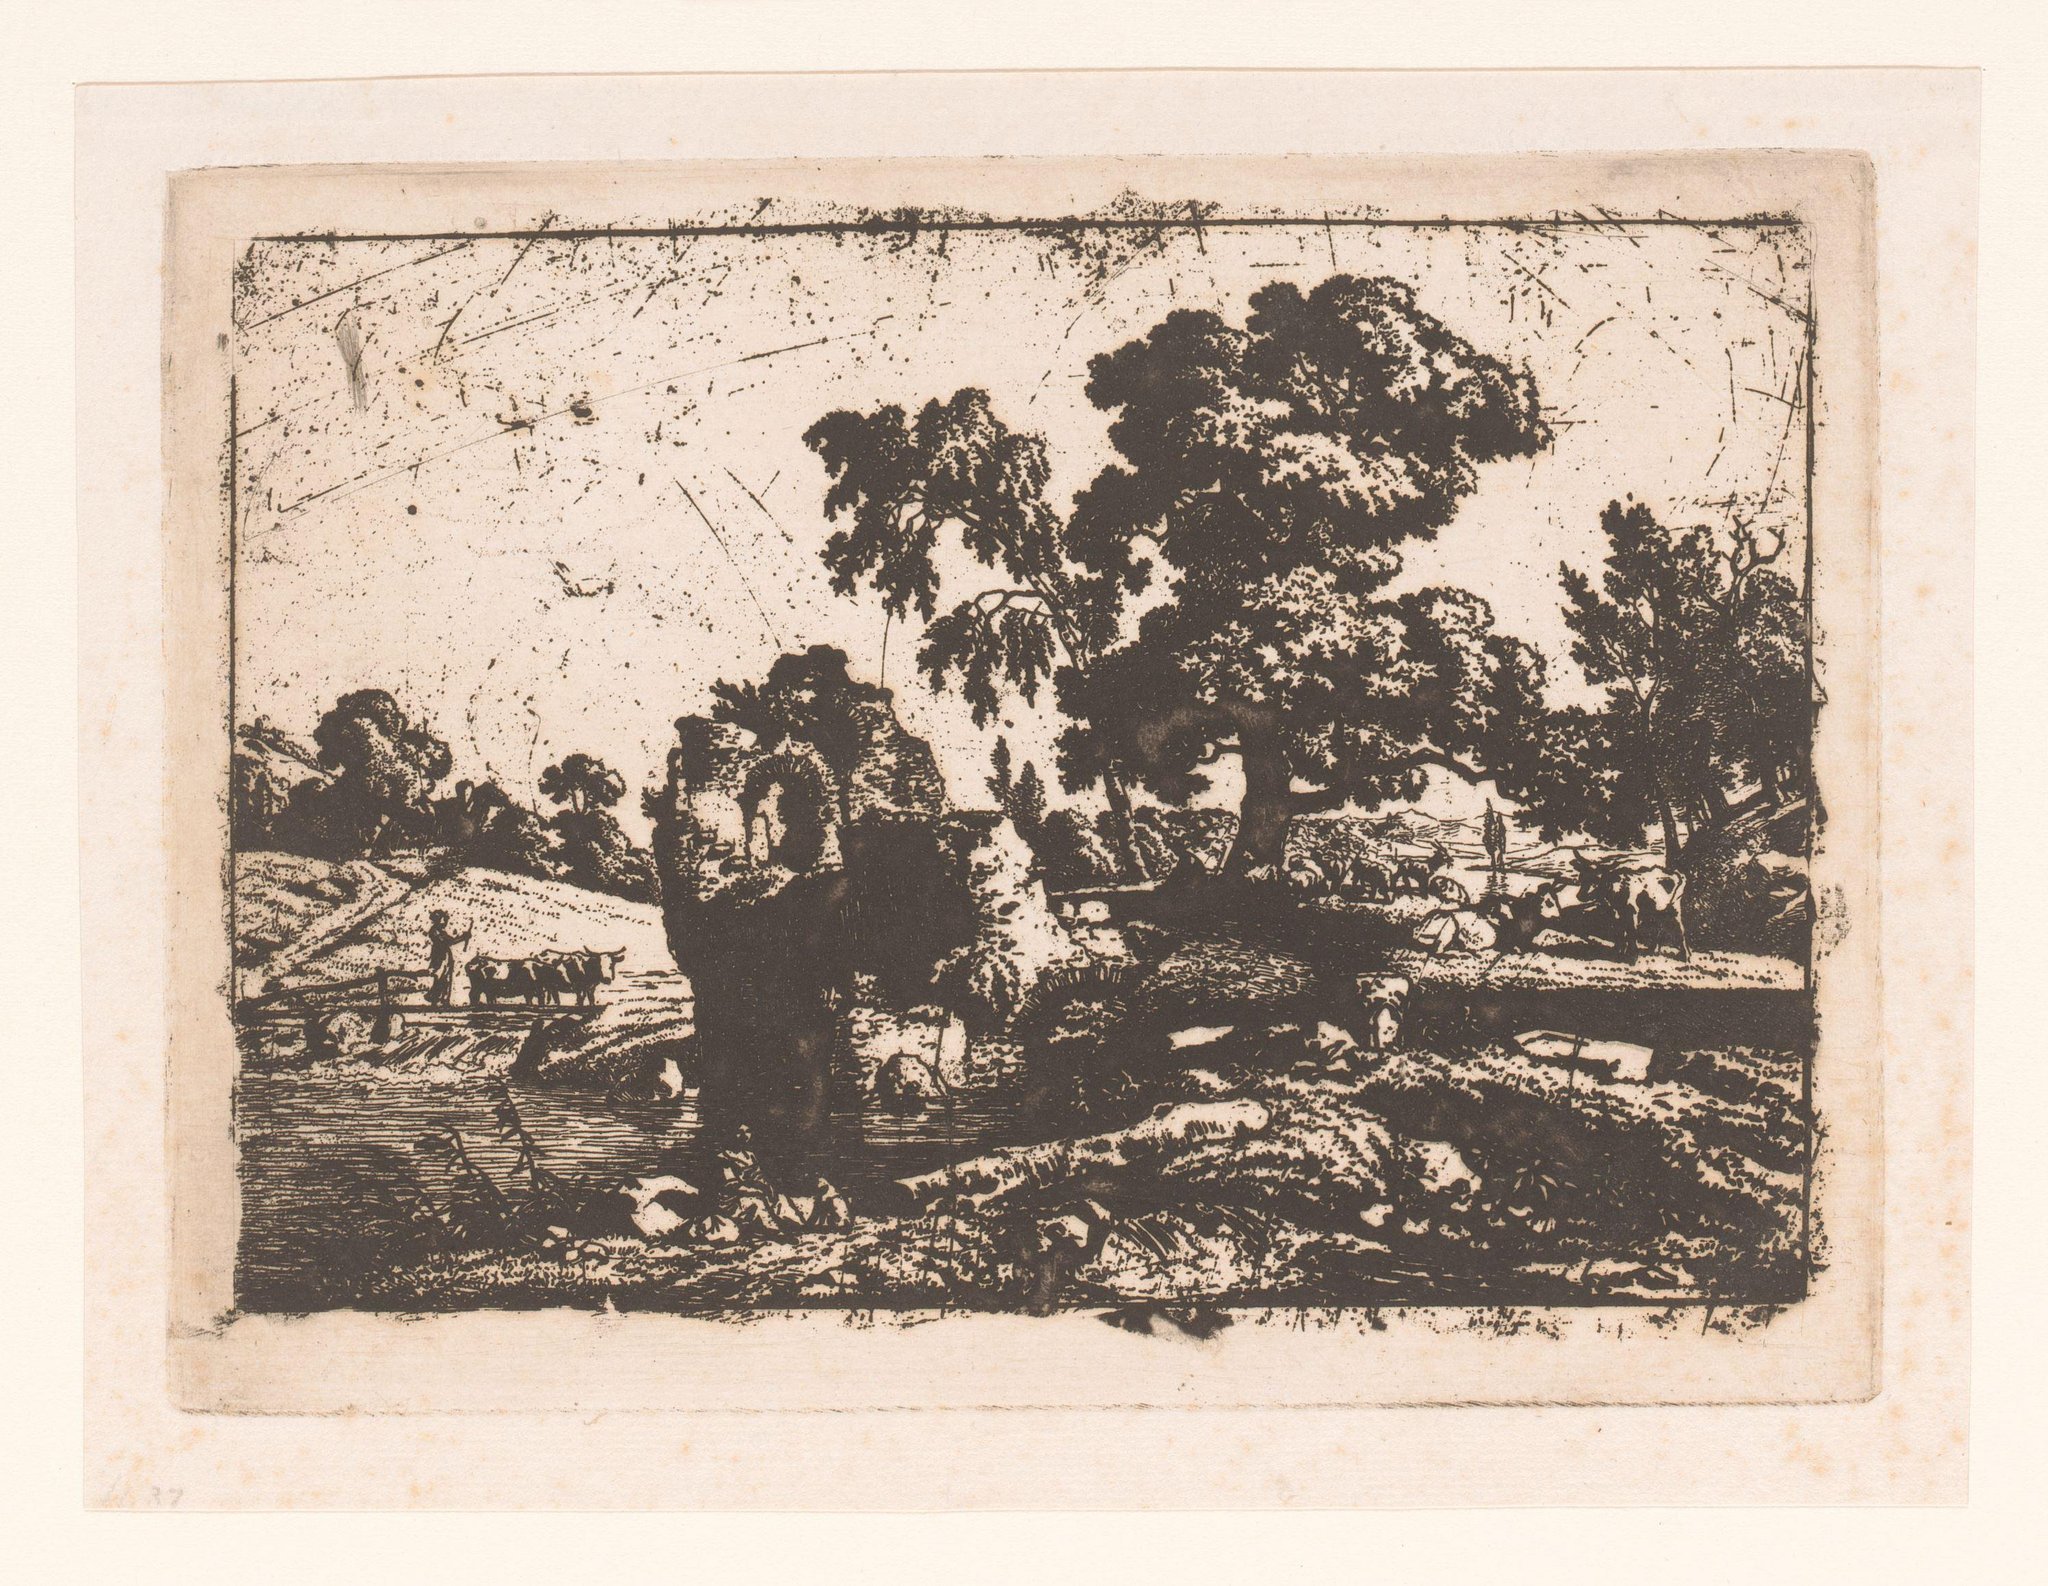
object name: print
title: Landschap met ruïne en herders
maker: jean louis demarne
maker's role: draughtsman, painter, print maker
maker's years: 1752-1829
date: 1762-1829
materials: paper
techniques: etching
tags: herding, herdsman, herdswoman, shepherd, shepherdess, cowherd, etc., landscape with ruins (+ city(-scape) with figures, staffage)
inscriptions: collector's mark: Lugt 2228